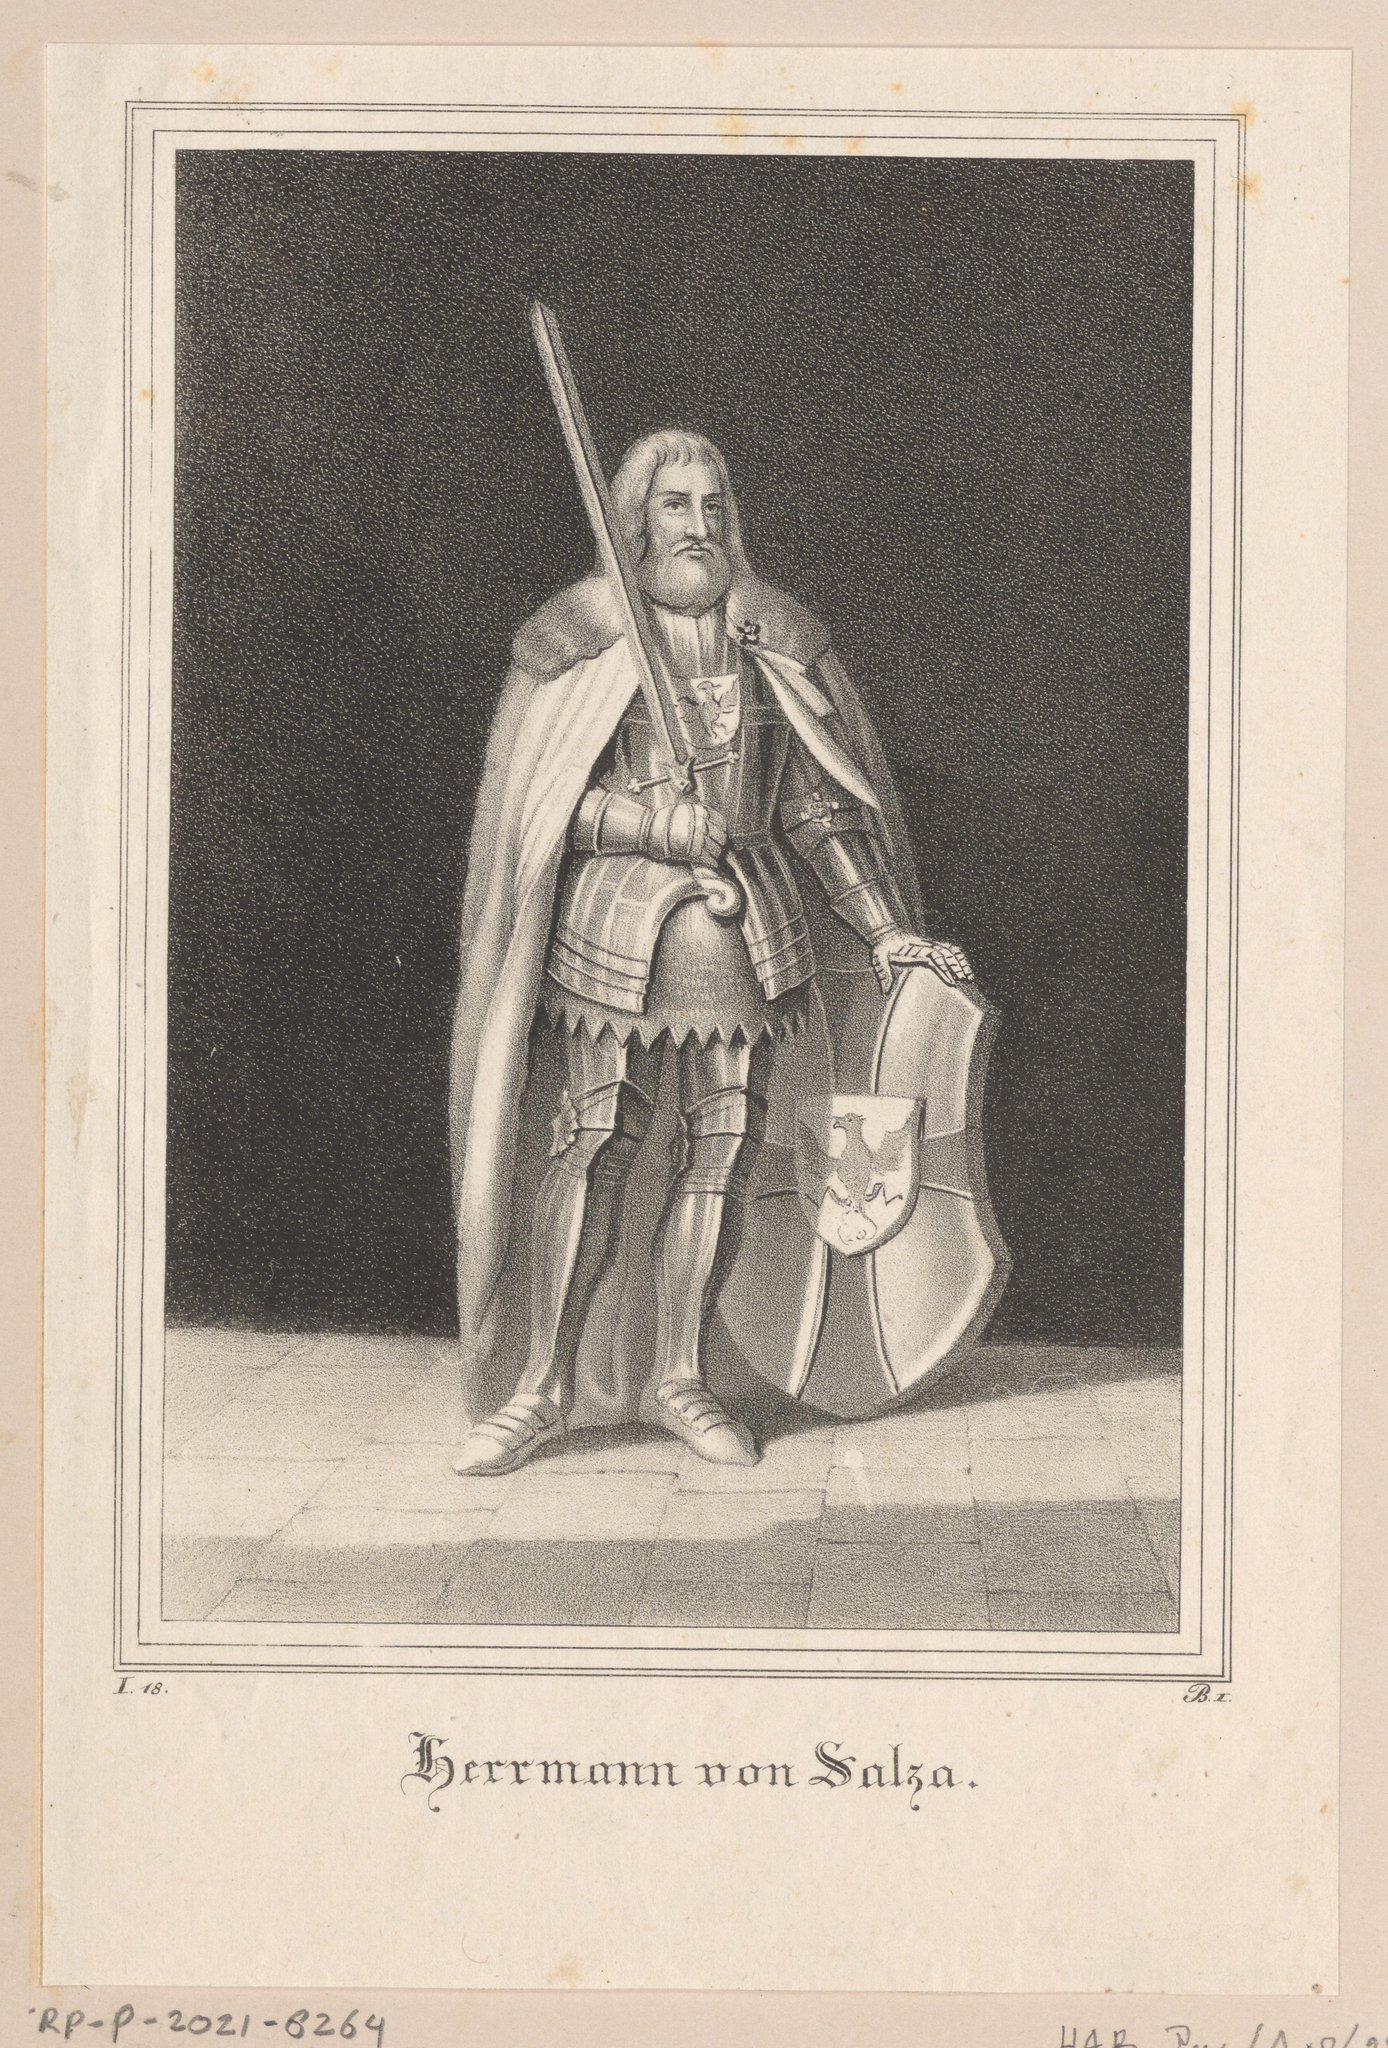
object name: print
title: Portret van Hermann von Salza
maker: Anonymous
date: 1838-1842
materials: paper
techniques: lithograph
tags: salerno, historical persons, diplomacy, diplomat, armorial bearing, heraldry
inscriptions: collector's mark: Lugt 2228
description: Prent mogelijk uit: Borussia, museum für Preussische Vaterlandskunde (...). Dresden: s.n., 1838-1842, dl. 1.